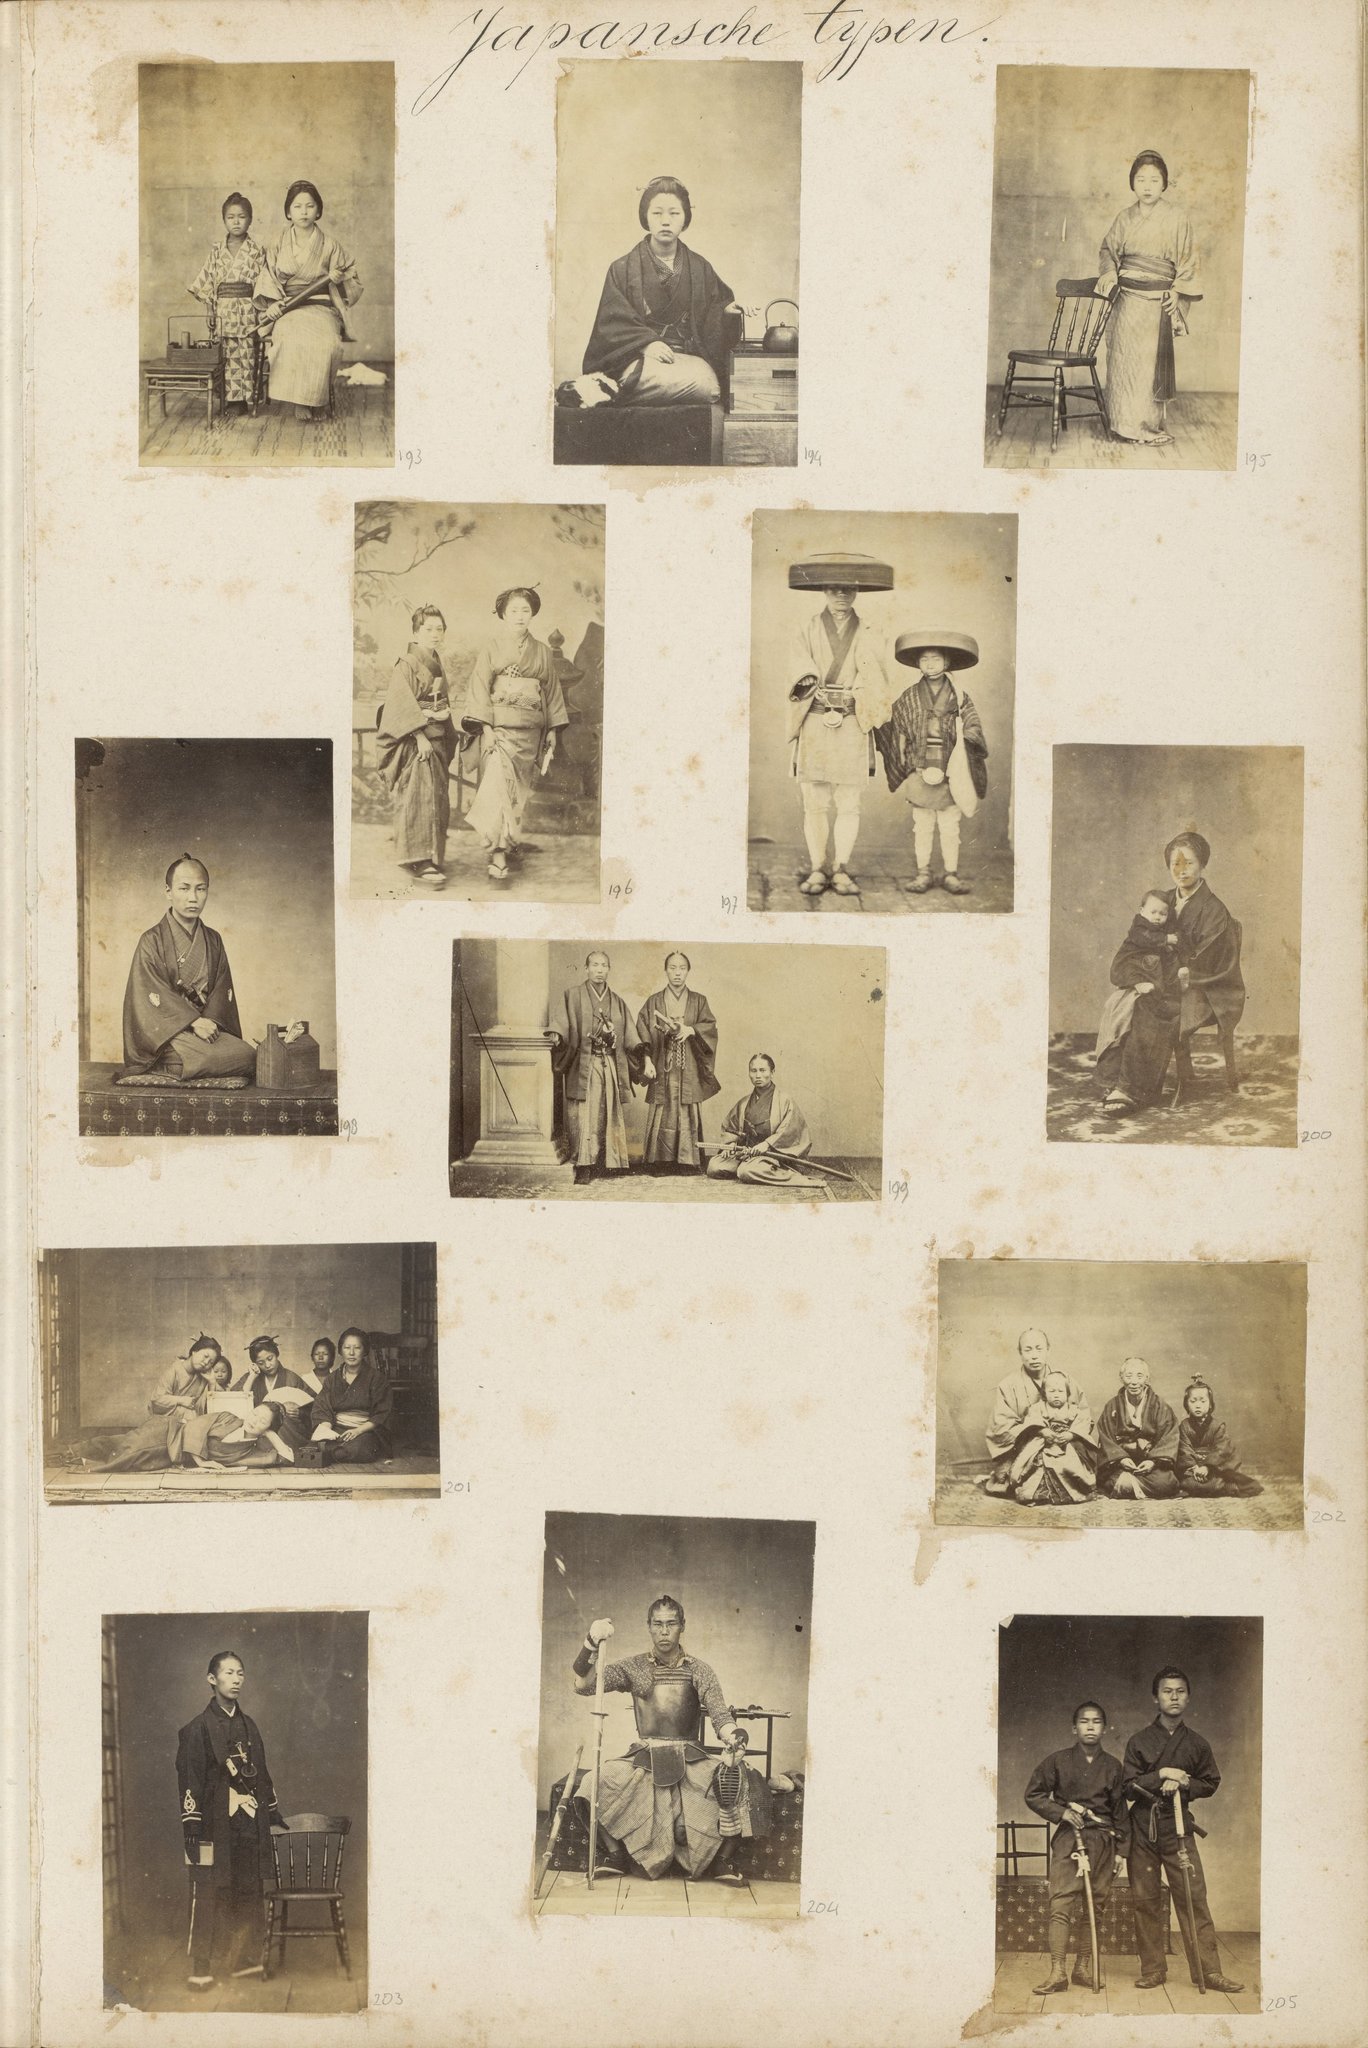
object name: photograph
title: Portret van een jonge Japanse vrouw staand bij een stoel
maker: Anonymous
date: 1870-1880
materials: paper, photographic support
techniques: albumen print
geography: japan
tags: adolescent, young woman, maiden, studio requisites ~ photographer, japan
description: Onderdeel van Fotoalbum van Robert Daniel Crommelin (1841-1907).